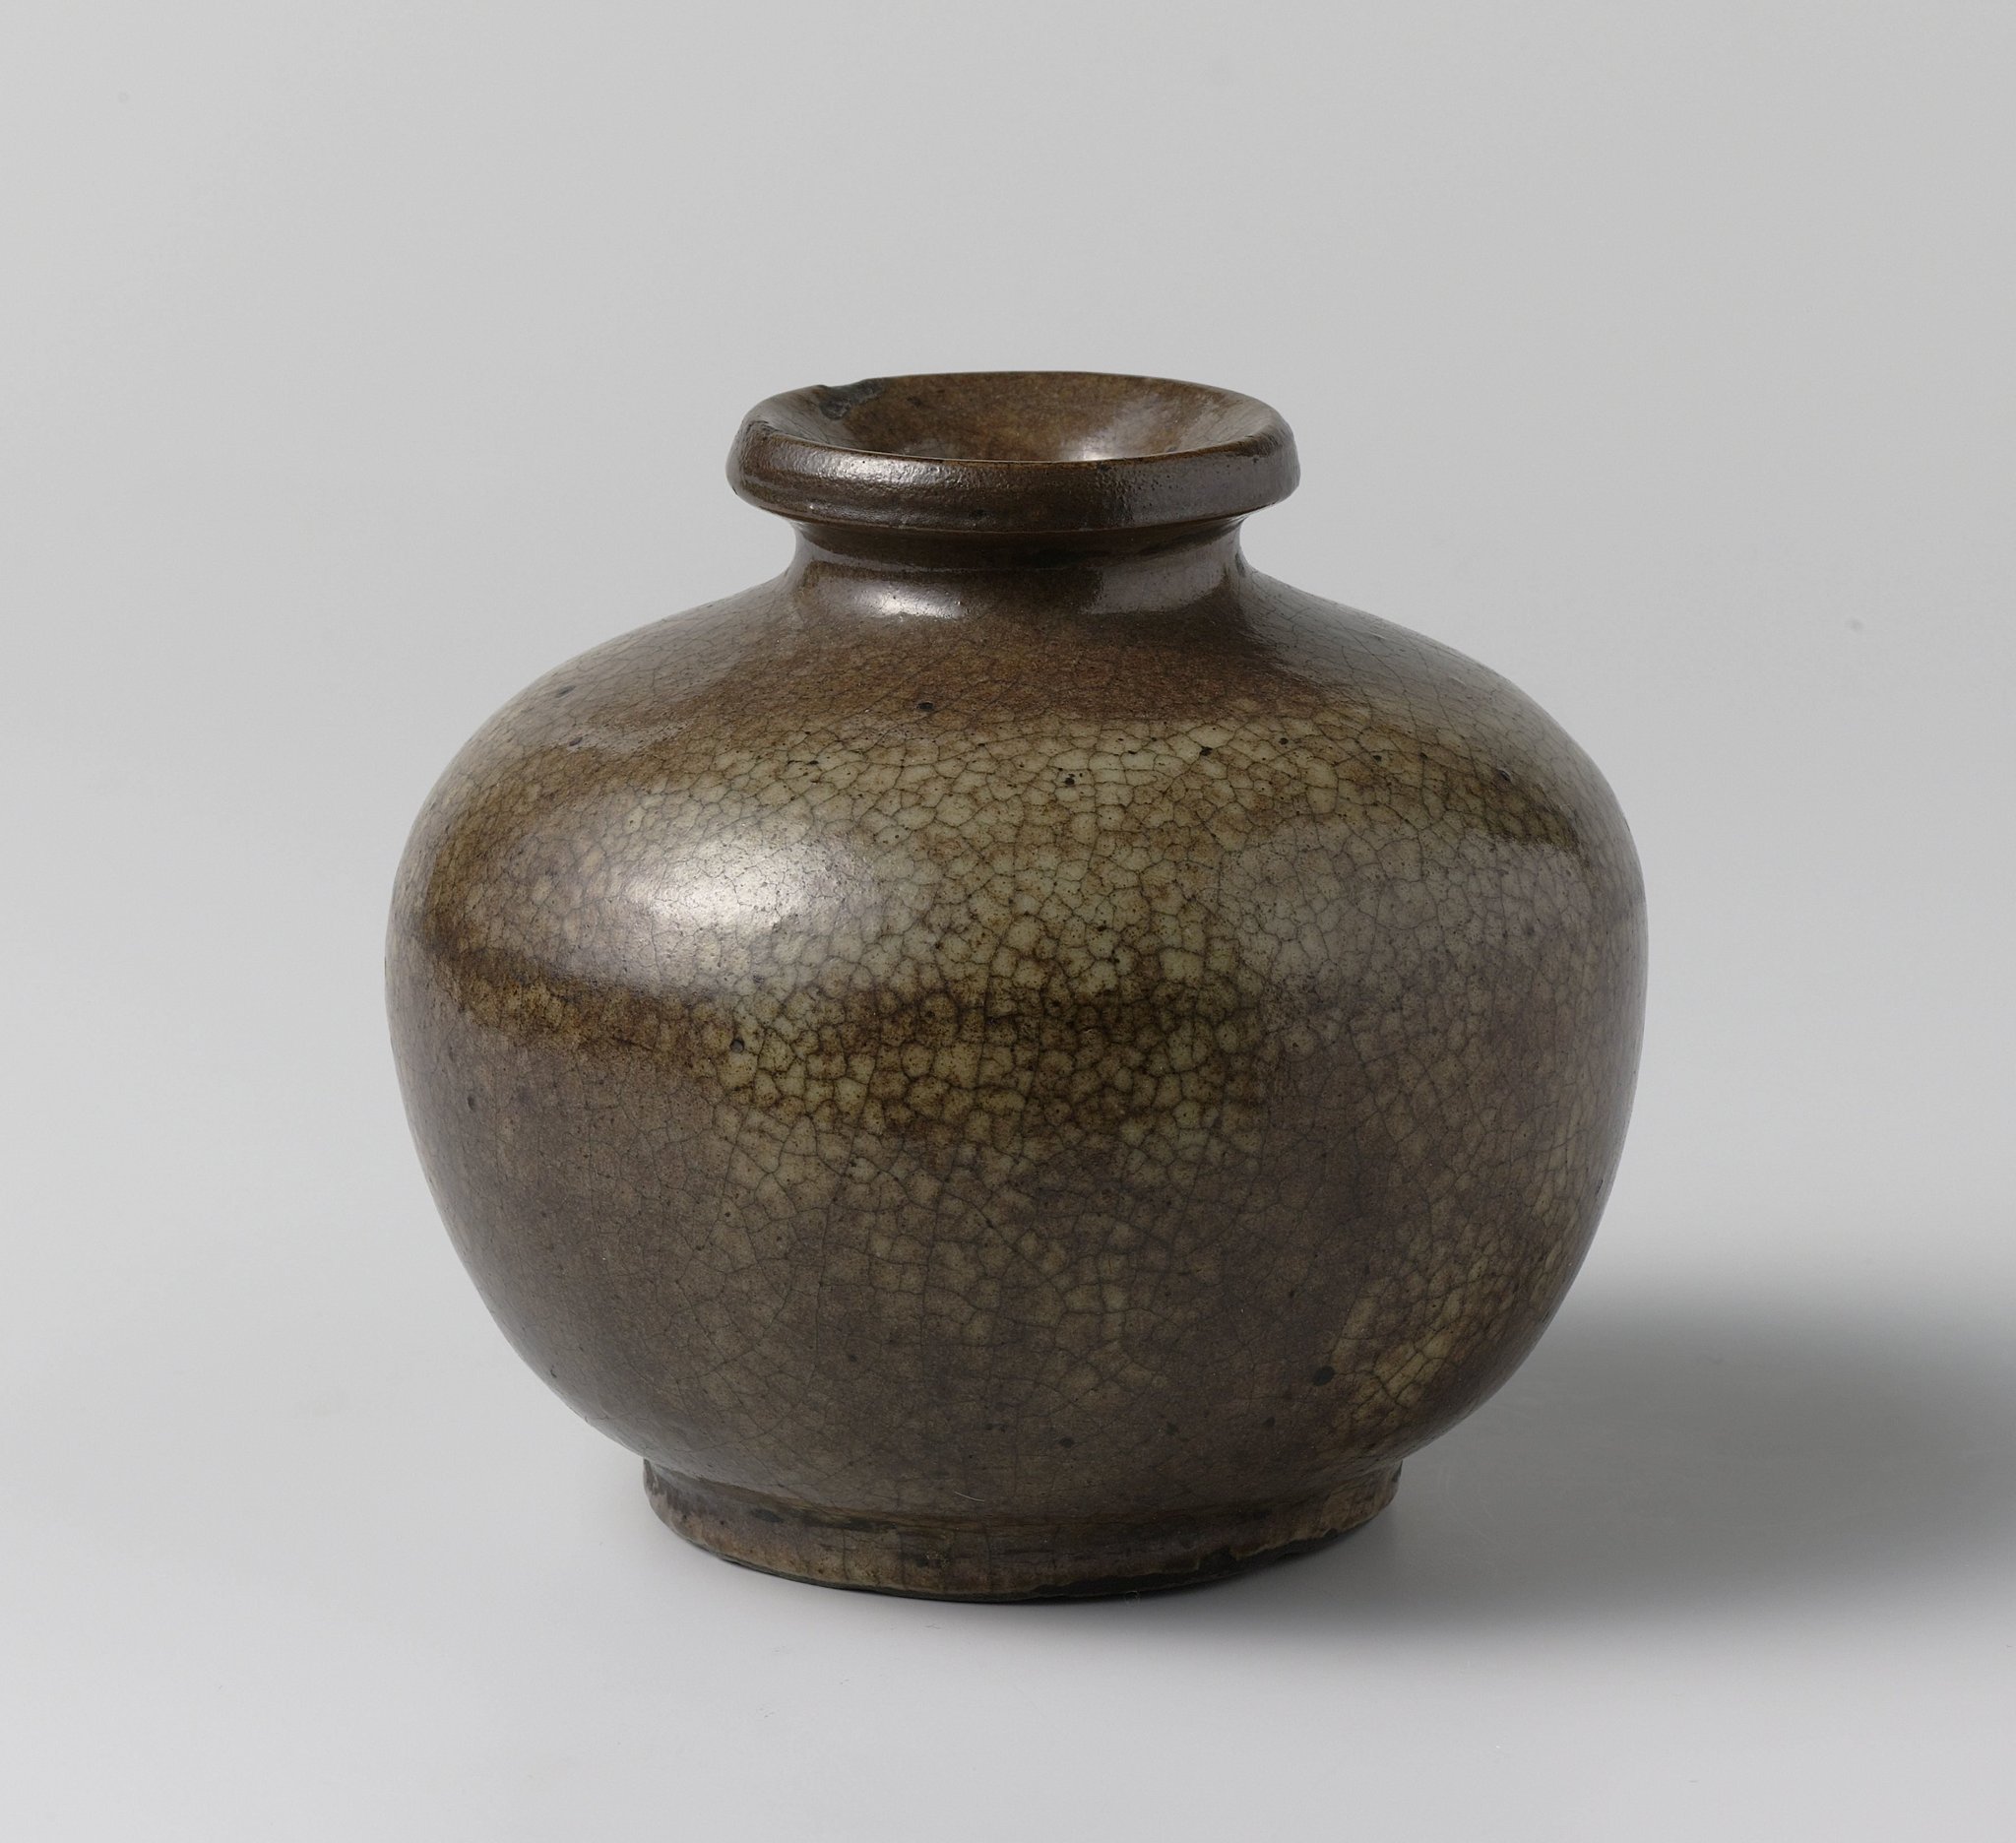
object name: bottle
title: Bottle with a brown glaze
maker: Anonymous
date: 1700-1799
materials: glaze, paint, stoneware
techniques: firing, turning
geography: karatsu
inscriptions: label: ‘W691’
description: Fles van steengoed met een eivormig lichaam en een korte, spreidende nek, bedekt met een gecraqueleerd crèmekleurig en bruin glazuur. Oud label op de onderzijde met 'W691'. Karatsu.